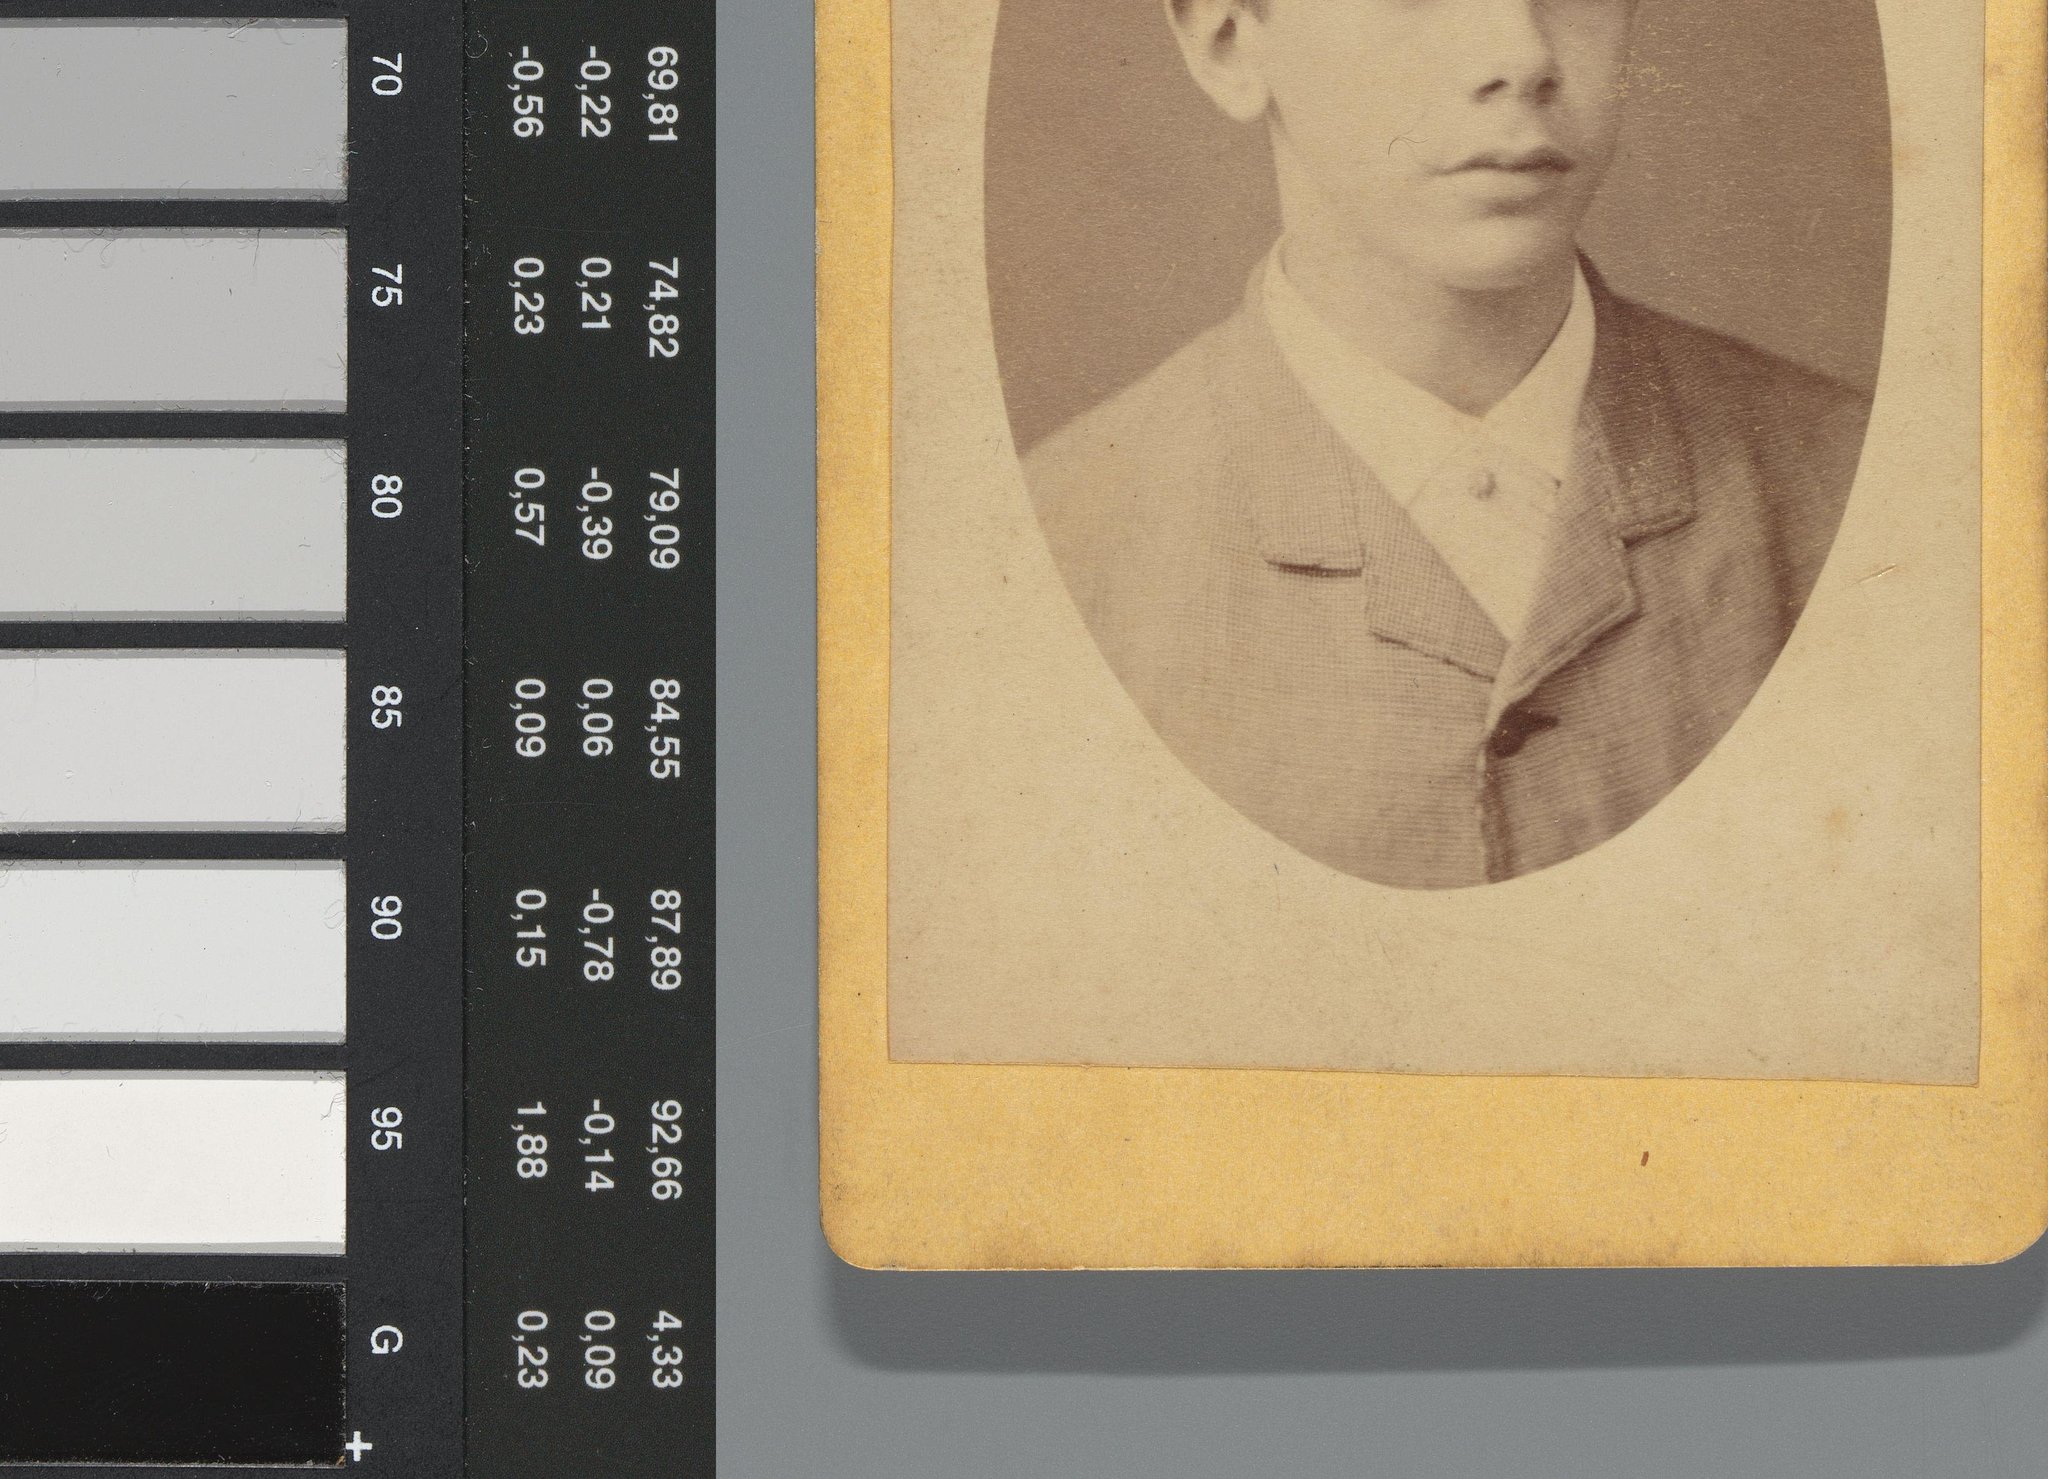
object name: carte de visite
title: Portret van Hendrik Herman van den Berg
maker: lo oij nam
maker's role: painter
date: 1889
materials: cardboard, photographic support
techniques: albumen print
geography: netherlands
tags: batavia, amsterdam, hendrik herman van den berg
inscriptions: name: ‘LO OIJ NAM / PHOTOGRAAF EN PORTRET-SCHILDER’, inscription: ‘Henk 1889 / 12 jaar’